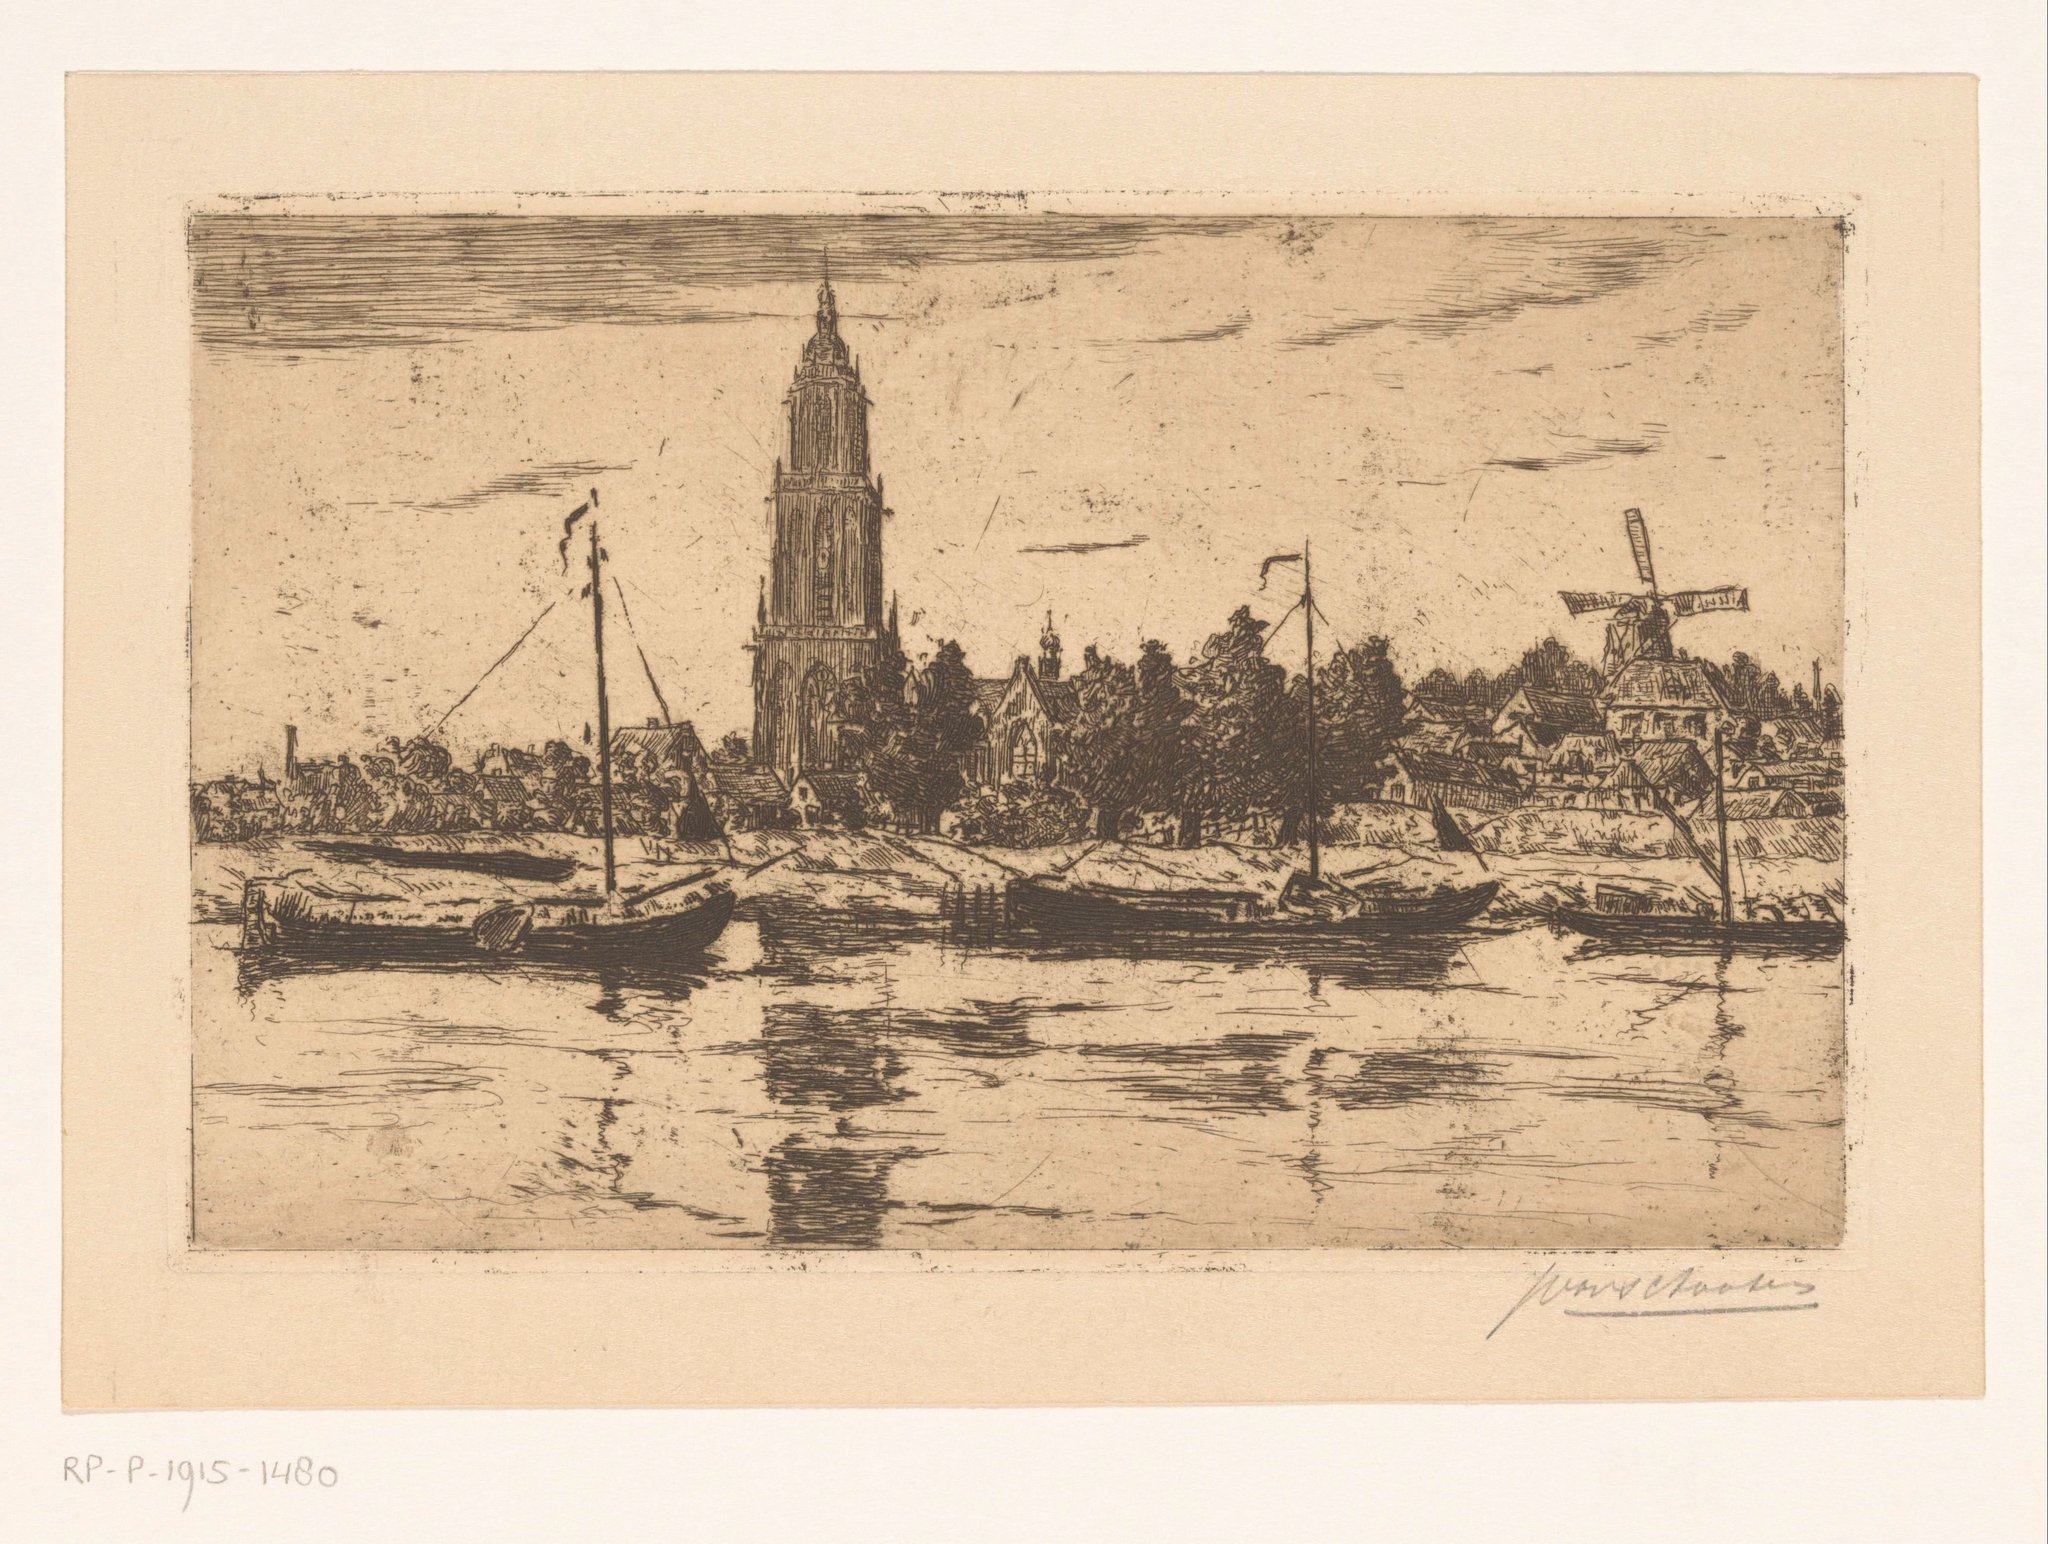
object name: print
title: Gezicht op Rhenen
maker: jan antonius van schooten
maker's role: print maker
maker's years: 1870-1933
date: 1880-1915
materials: paper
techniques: etching, intaglio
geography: netherlands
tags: city-view in general; 'veduta', river, parts of church exterior and annexes: tower, lower rhine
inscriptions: collector's mark: Lugt 2233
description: Op de voorgrond de Nederrijn. Links de toren van de Cunerakerk; rechts een molen.